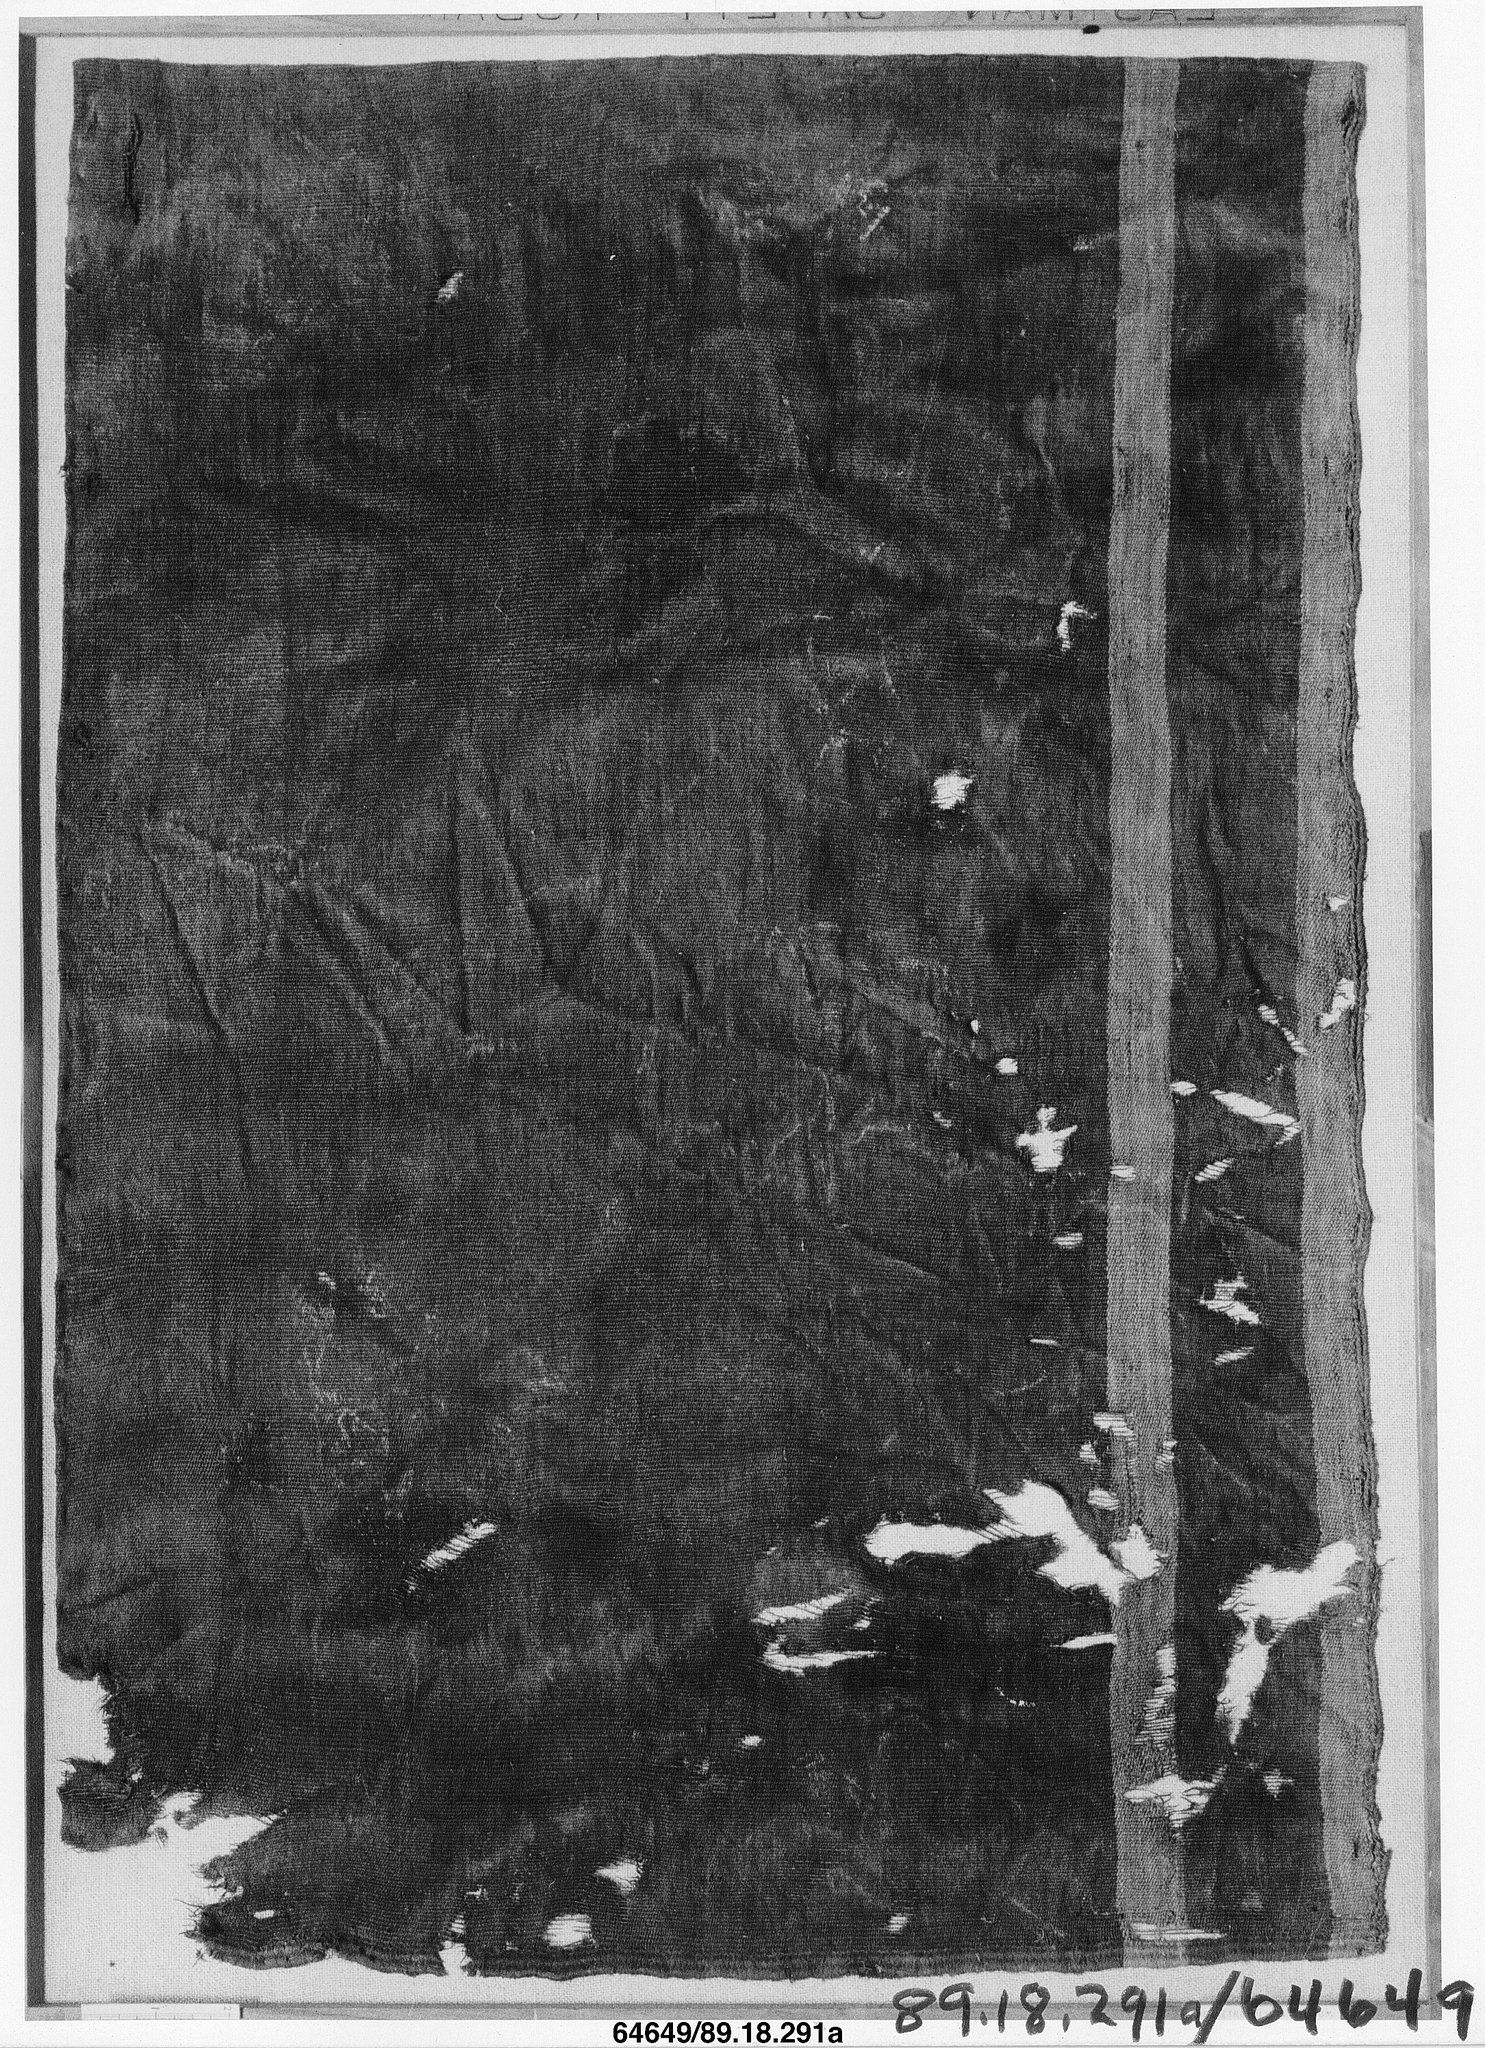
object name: textile fragment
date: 401-700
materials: wool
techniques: weave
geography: egypt